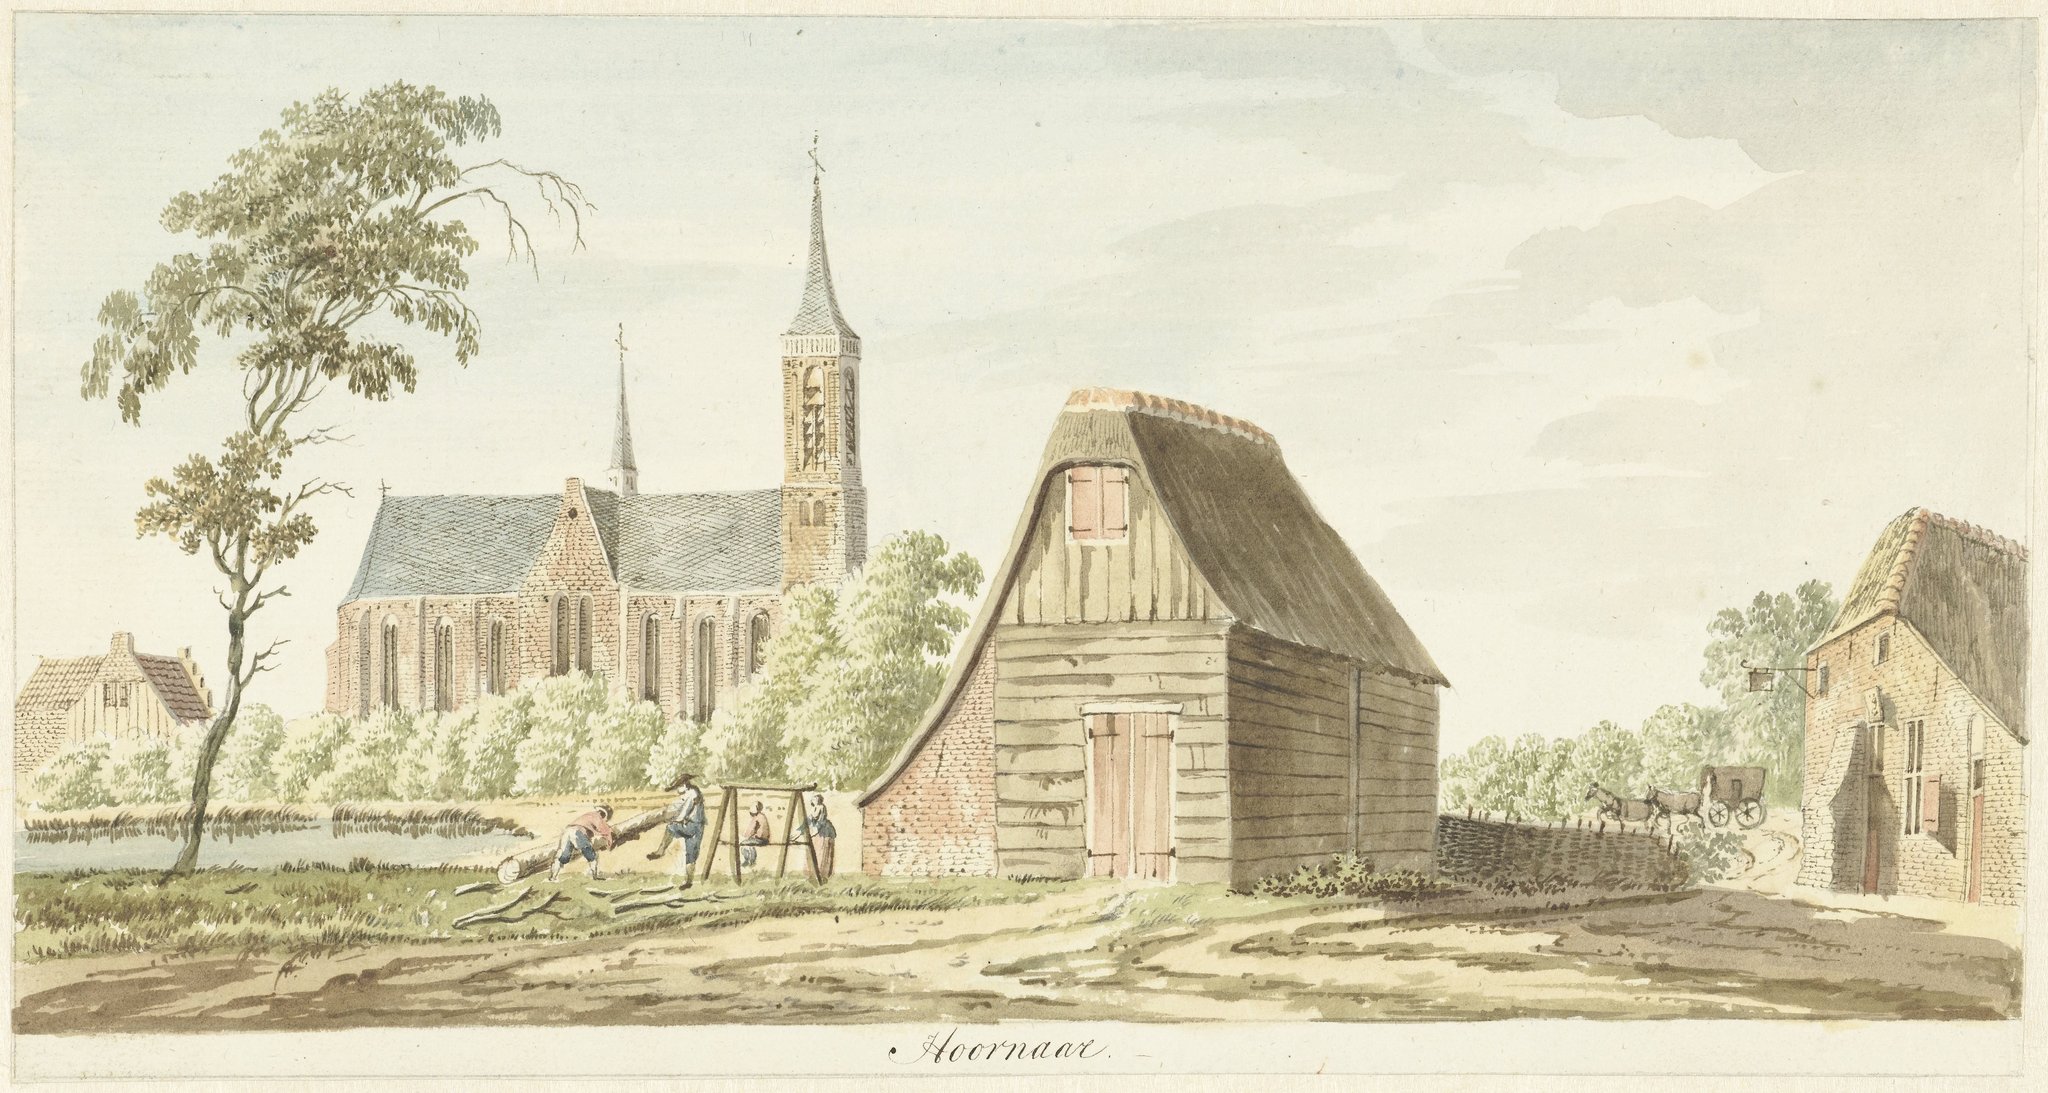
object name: watercolor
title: Gezicht op het dorp Hoornaar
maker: hendrik tavenier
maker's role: draughtsman, print maker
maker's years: 1734-1807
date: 1784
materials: ink, paper, watercolor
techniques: brush, pen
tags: village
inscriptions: inscription: ‘Hoornaar 1785 H: Tavenier’